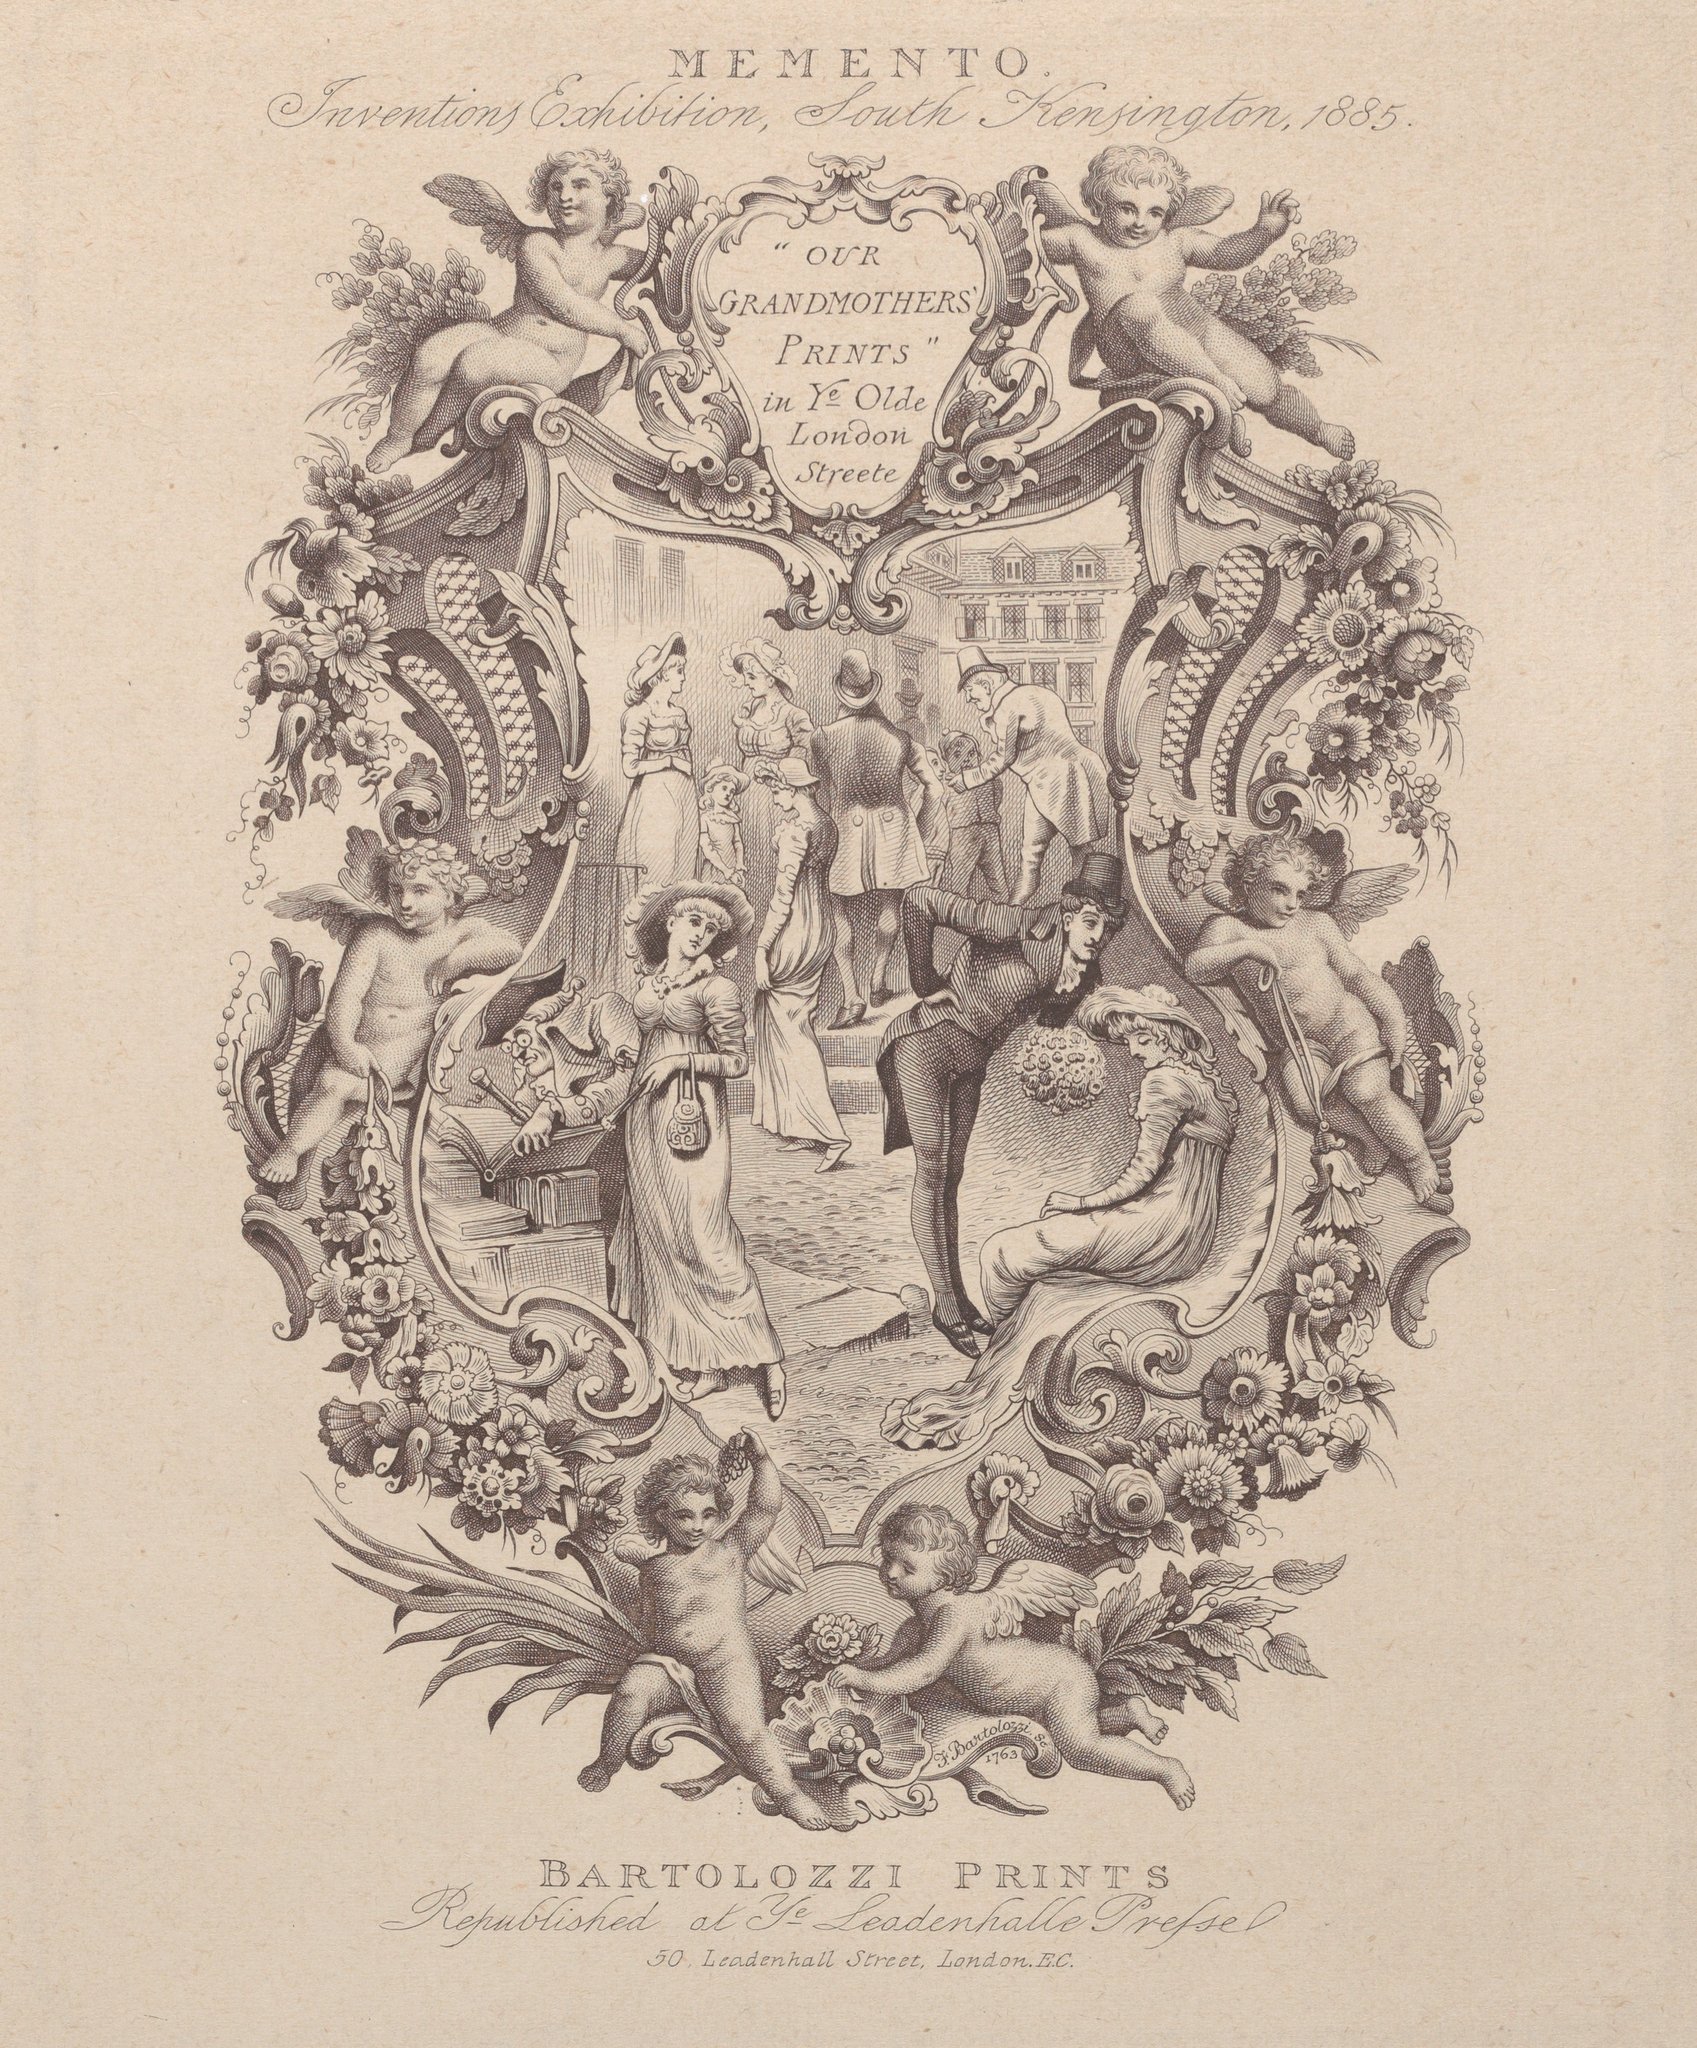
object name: print, trade card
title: Advertisement for Memento, Inventions Exhibition, South Kensington, 1885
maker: francesco bartolozzi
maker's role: artist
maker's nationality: italian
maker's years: 1728-1815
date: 1885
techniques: engraving